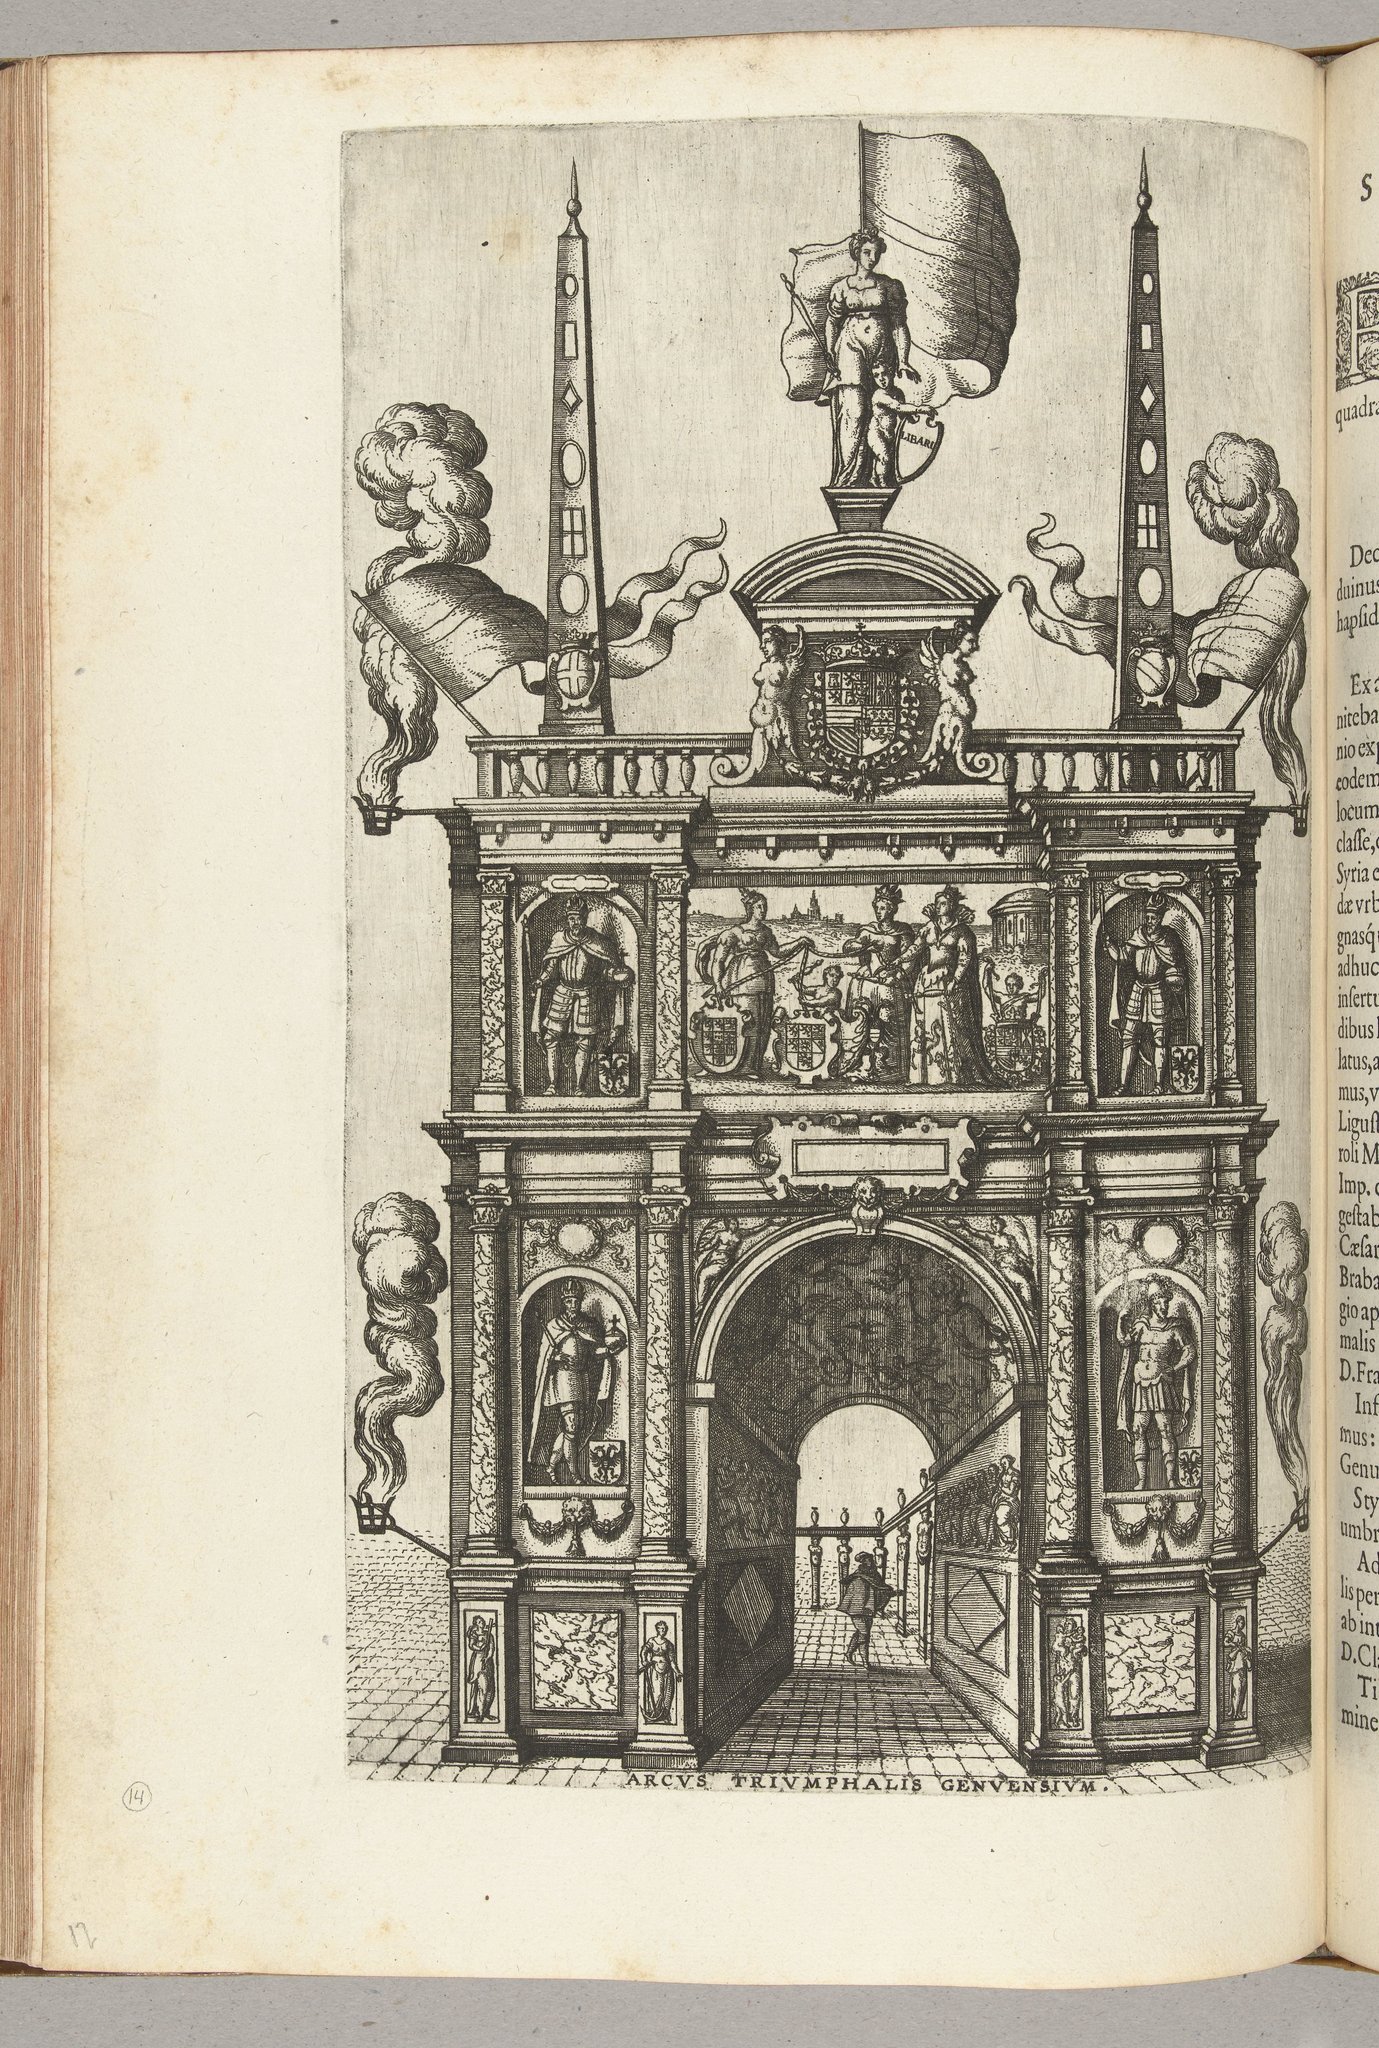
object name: print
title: Arcus Triumphalis Genuensium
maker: pieter van der borcht (i)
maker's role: print maker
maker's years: 1545-1608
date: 1594-1595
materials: paper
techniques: etching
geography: southern netherlands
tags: brussels, triumphal entry and public reception, pageant, 'entrée solennelle', 'joyeuse entrée', antwerp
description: Triomfboog van Genua (voorzijde). Opgericht op de Meir bij de Lange Klarenstraat. Onderdeel van de beschrijving van de intocht van aartshertog Ernst te Antwerpen, 18 juli 1594, door Joannes Bochius, Descriptio publicae gratulationis, spectaculorum et ludorum, in adventu Sereniss. Principis Ernesti Archiducis Austriae, Ex Officina Plantiniana, Antwerpen 1595.